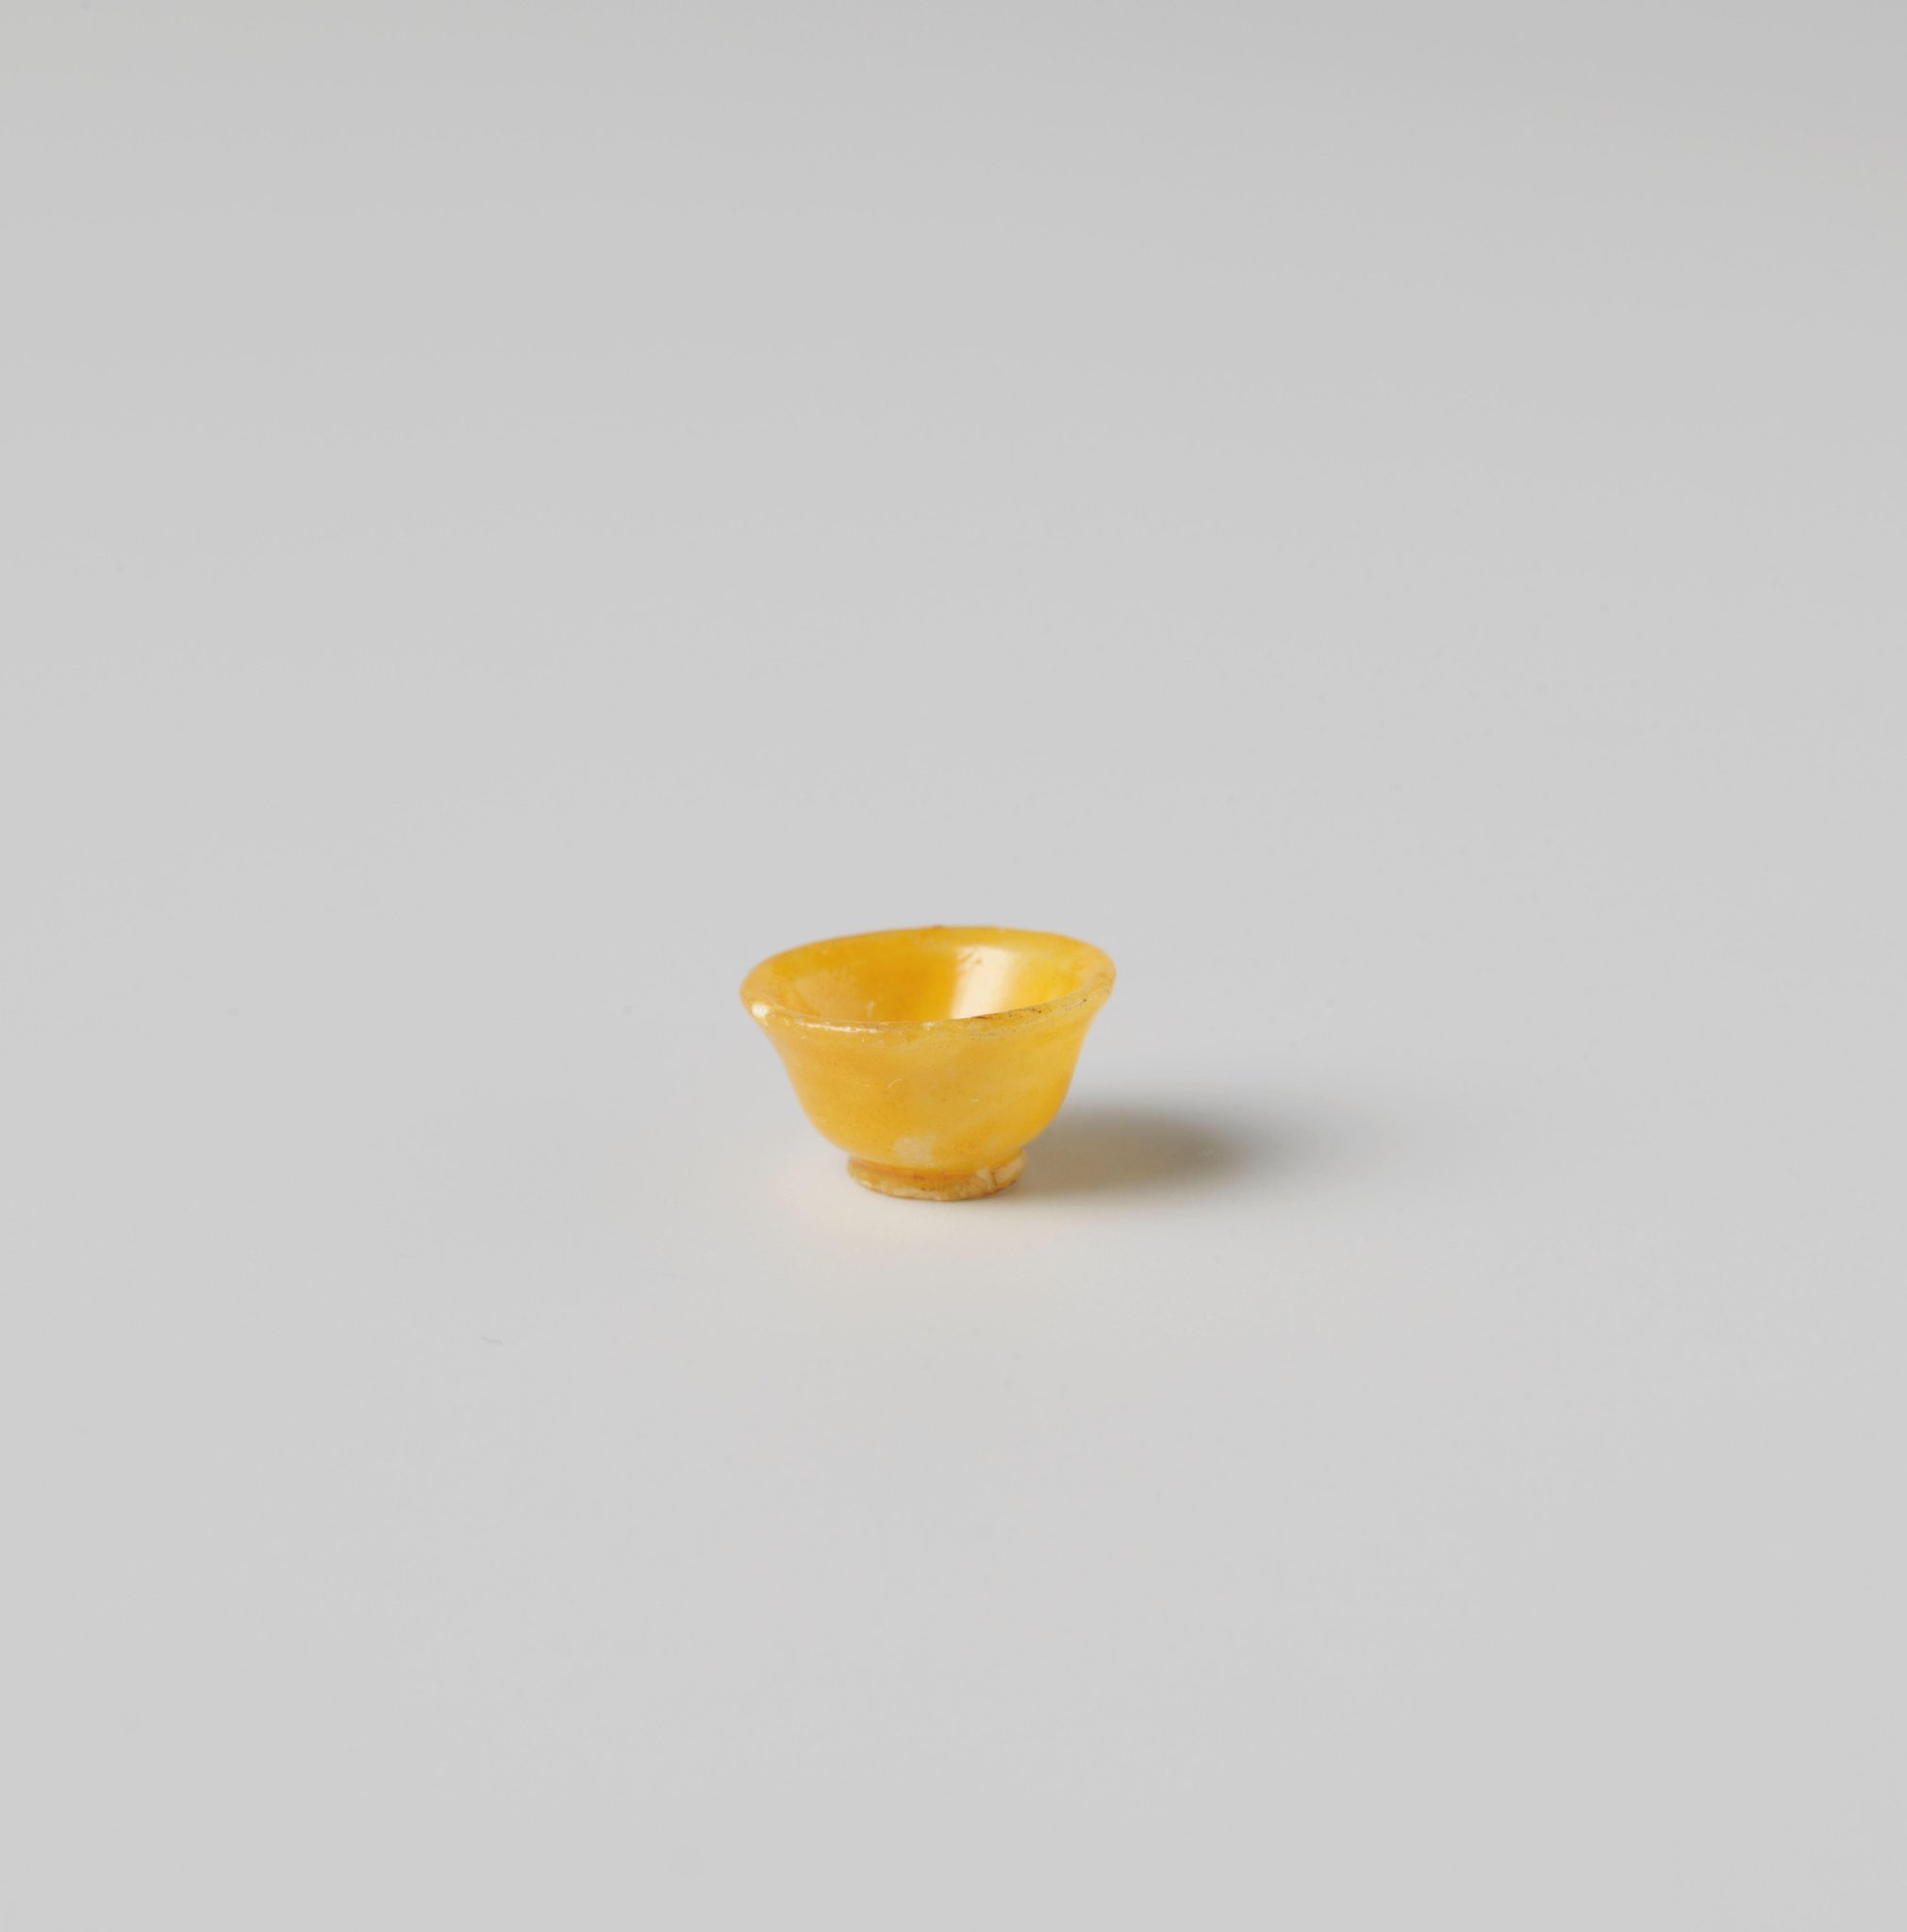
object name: miniature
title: Kom, geelgelakt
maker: Anonymous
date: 1750-1800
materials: alabaster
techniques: lacquer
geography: germany